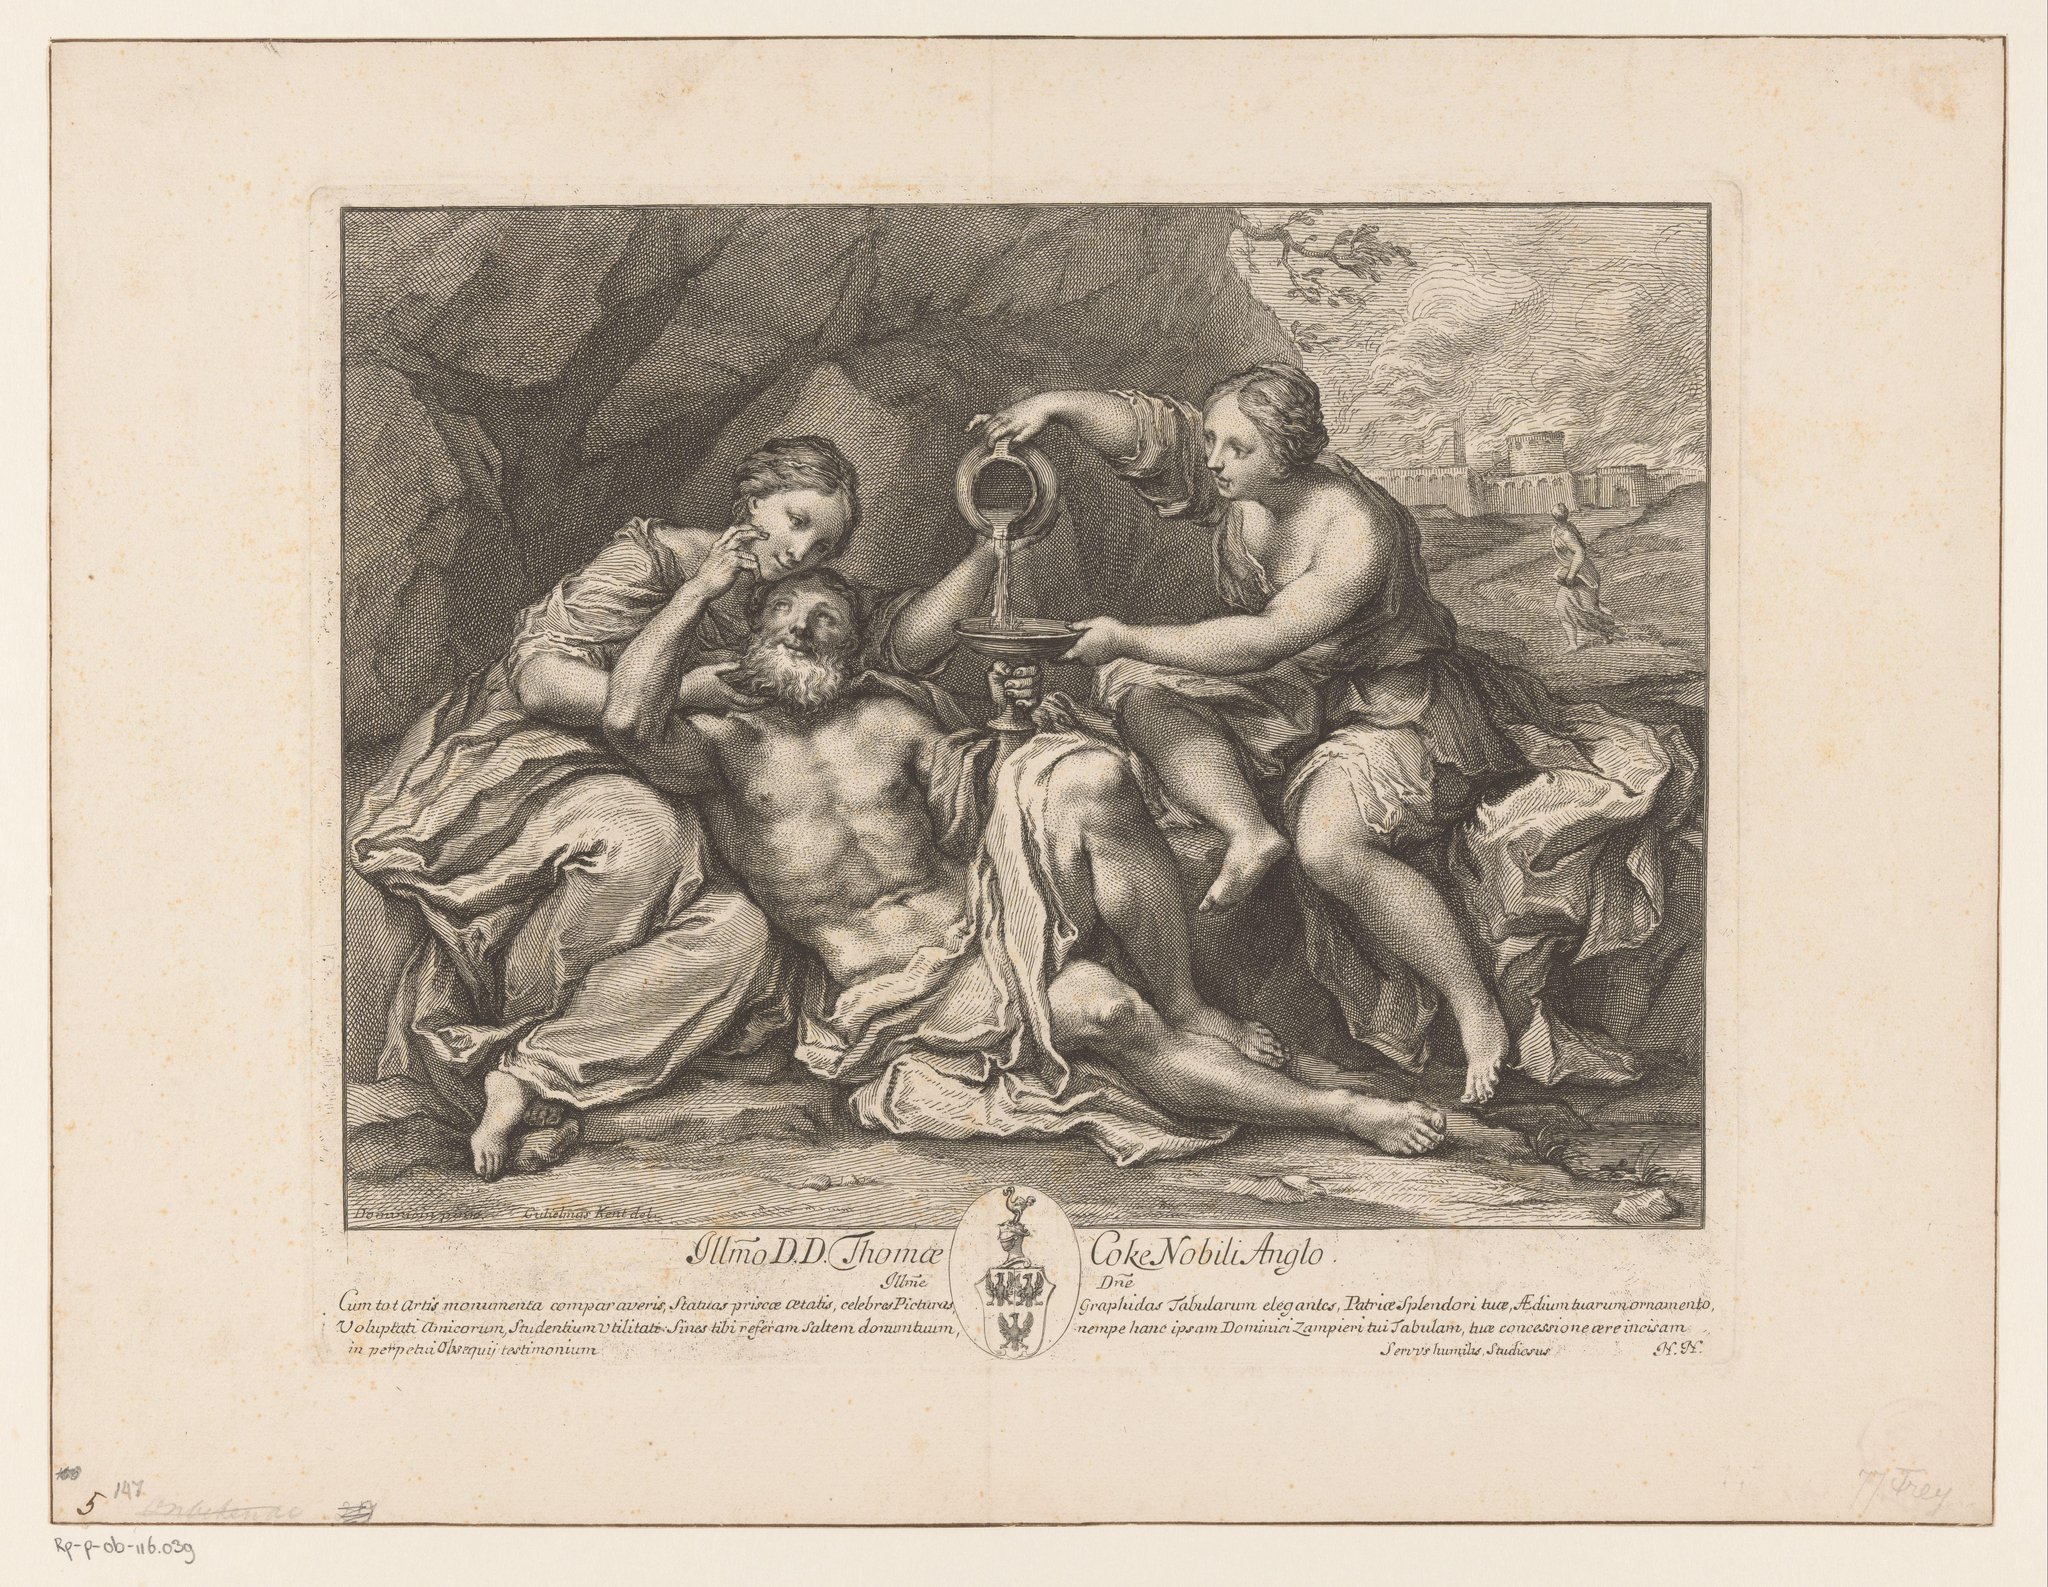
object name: print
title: Lot en zijn dochters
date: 1718-1719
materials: paper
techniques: engraving, etching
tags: lot and his daughters (genesis 19:30-38), the destruction of sodom and gomorrah: lot and his family flee to zoar, carrying their belongings; an angel may be showing the way (genesis 19:24-29), armorial bearing, heraldry, lot's daughters make their father drunk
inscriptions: collector's mark: Lugt 240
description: Op de achtergrond rent een vrouw weg van de brandende steden Sodom en Gomorra. Met onderschrift in het Latijn.